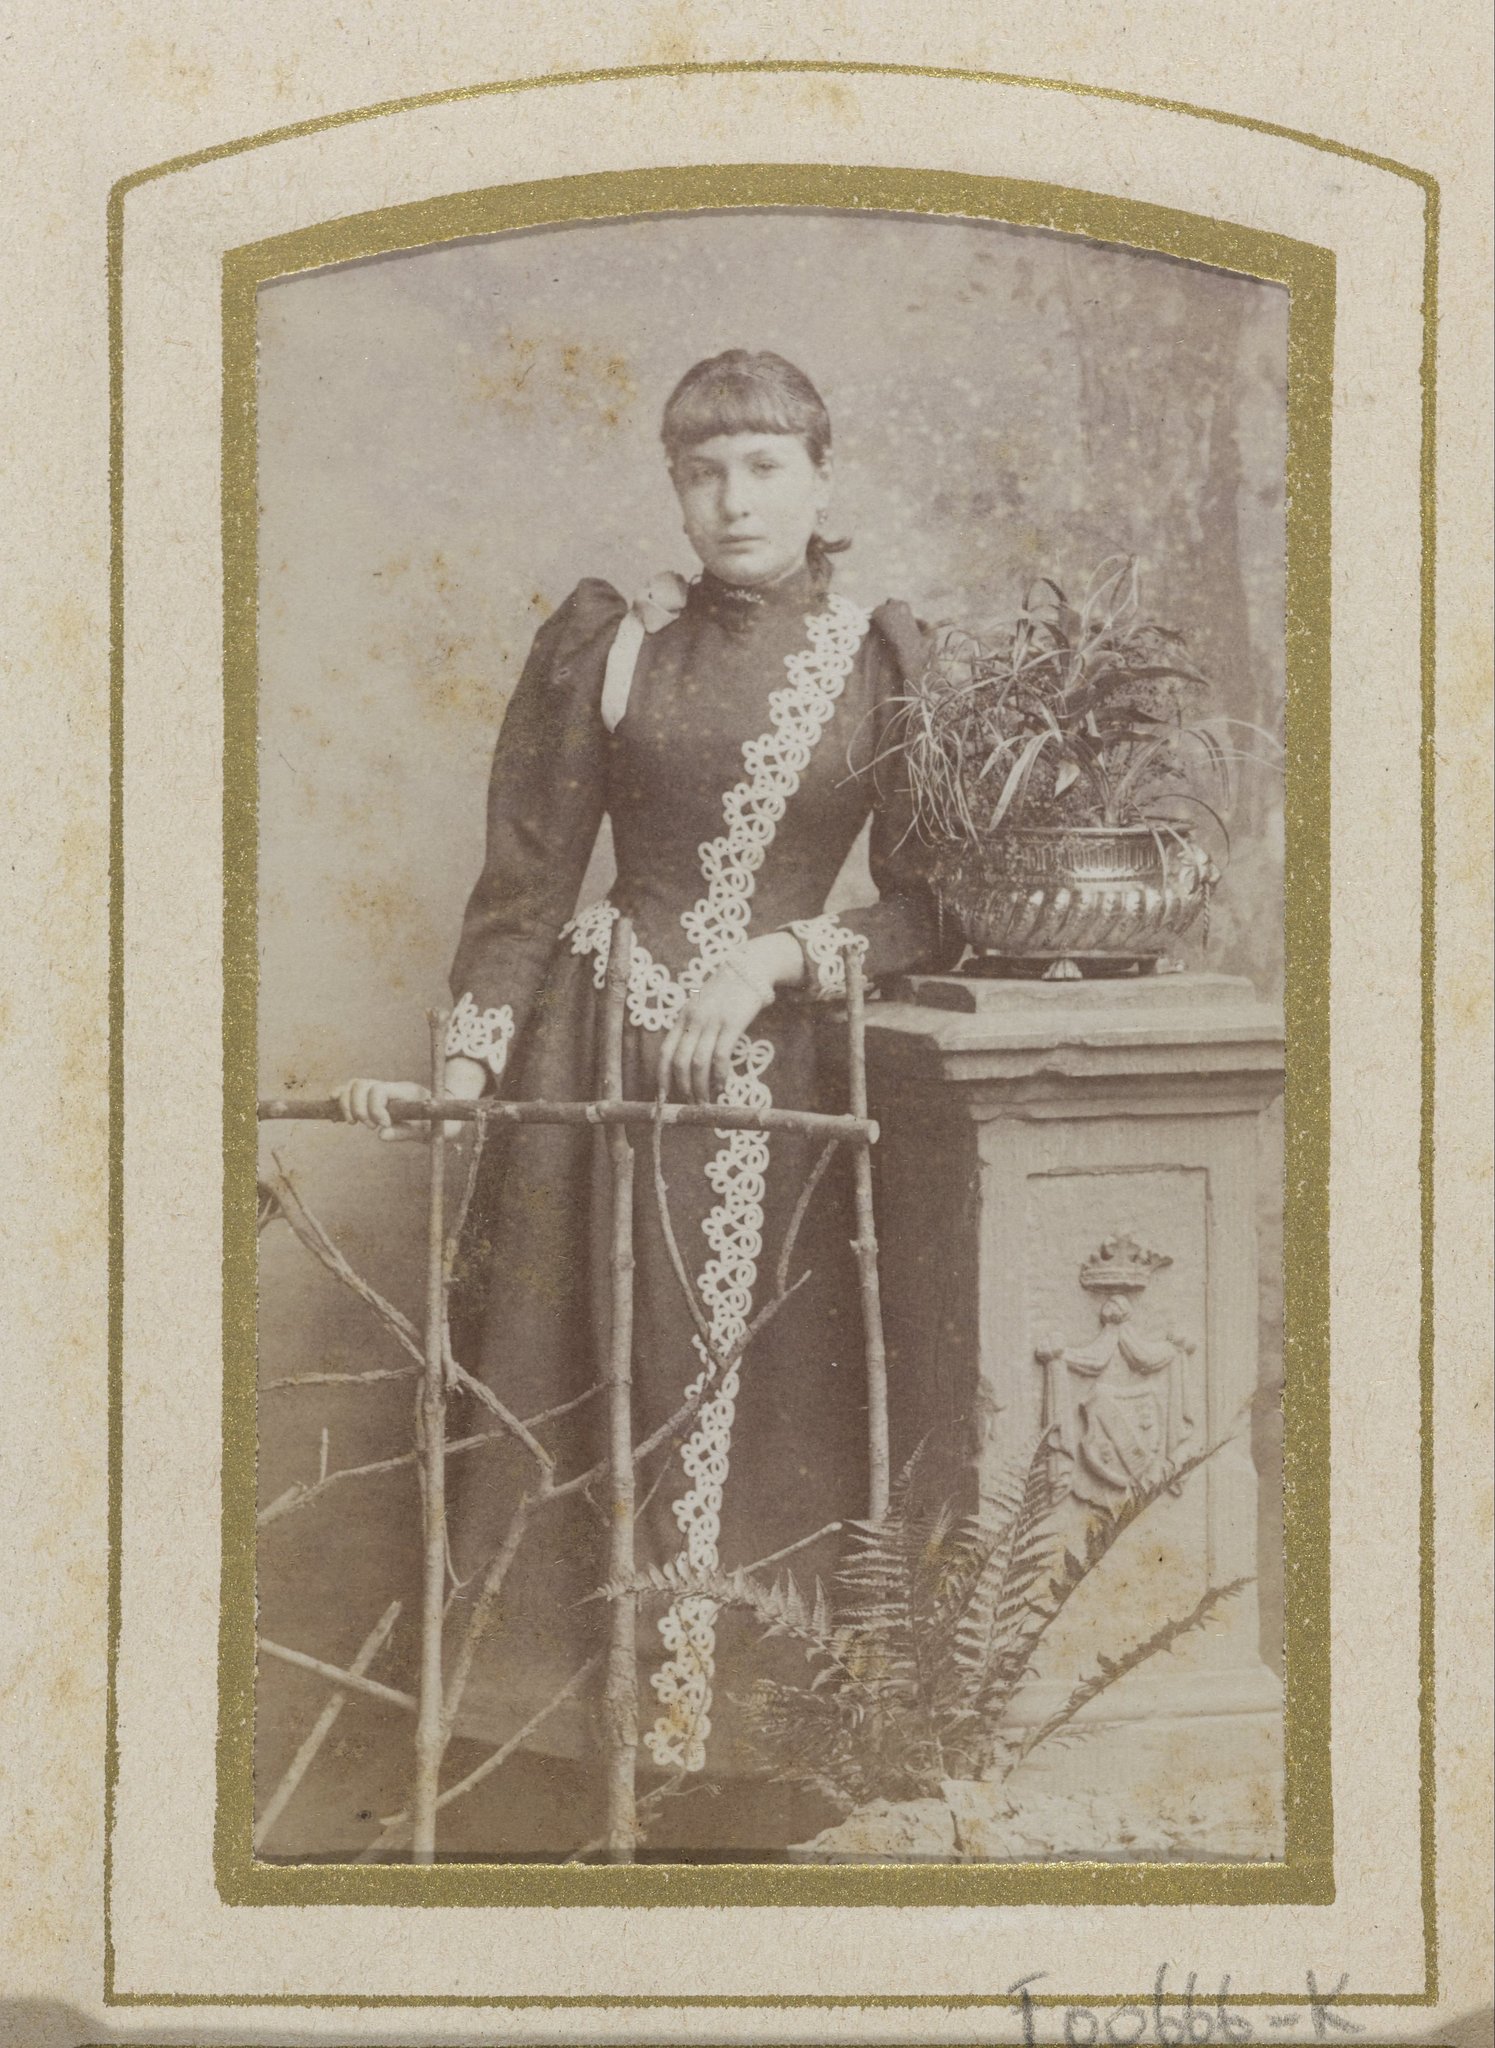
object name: photograph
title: Portret van een staande vrouw bij een hek en een sokkel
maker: jan goedeljee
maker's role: fotograaf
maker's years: 1824-1905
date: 1860-1905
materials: cardboard, photographic support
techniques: albumen print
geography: leiden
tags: historical persons - bb - woman, fence, wall, paling, pedestal of a piece of sculpture (perhaps in the form of a herm)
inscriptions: inscription: ‘geboren/ gephotografeerd’